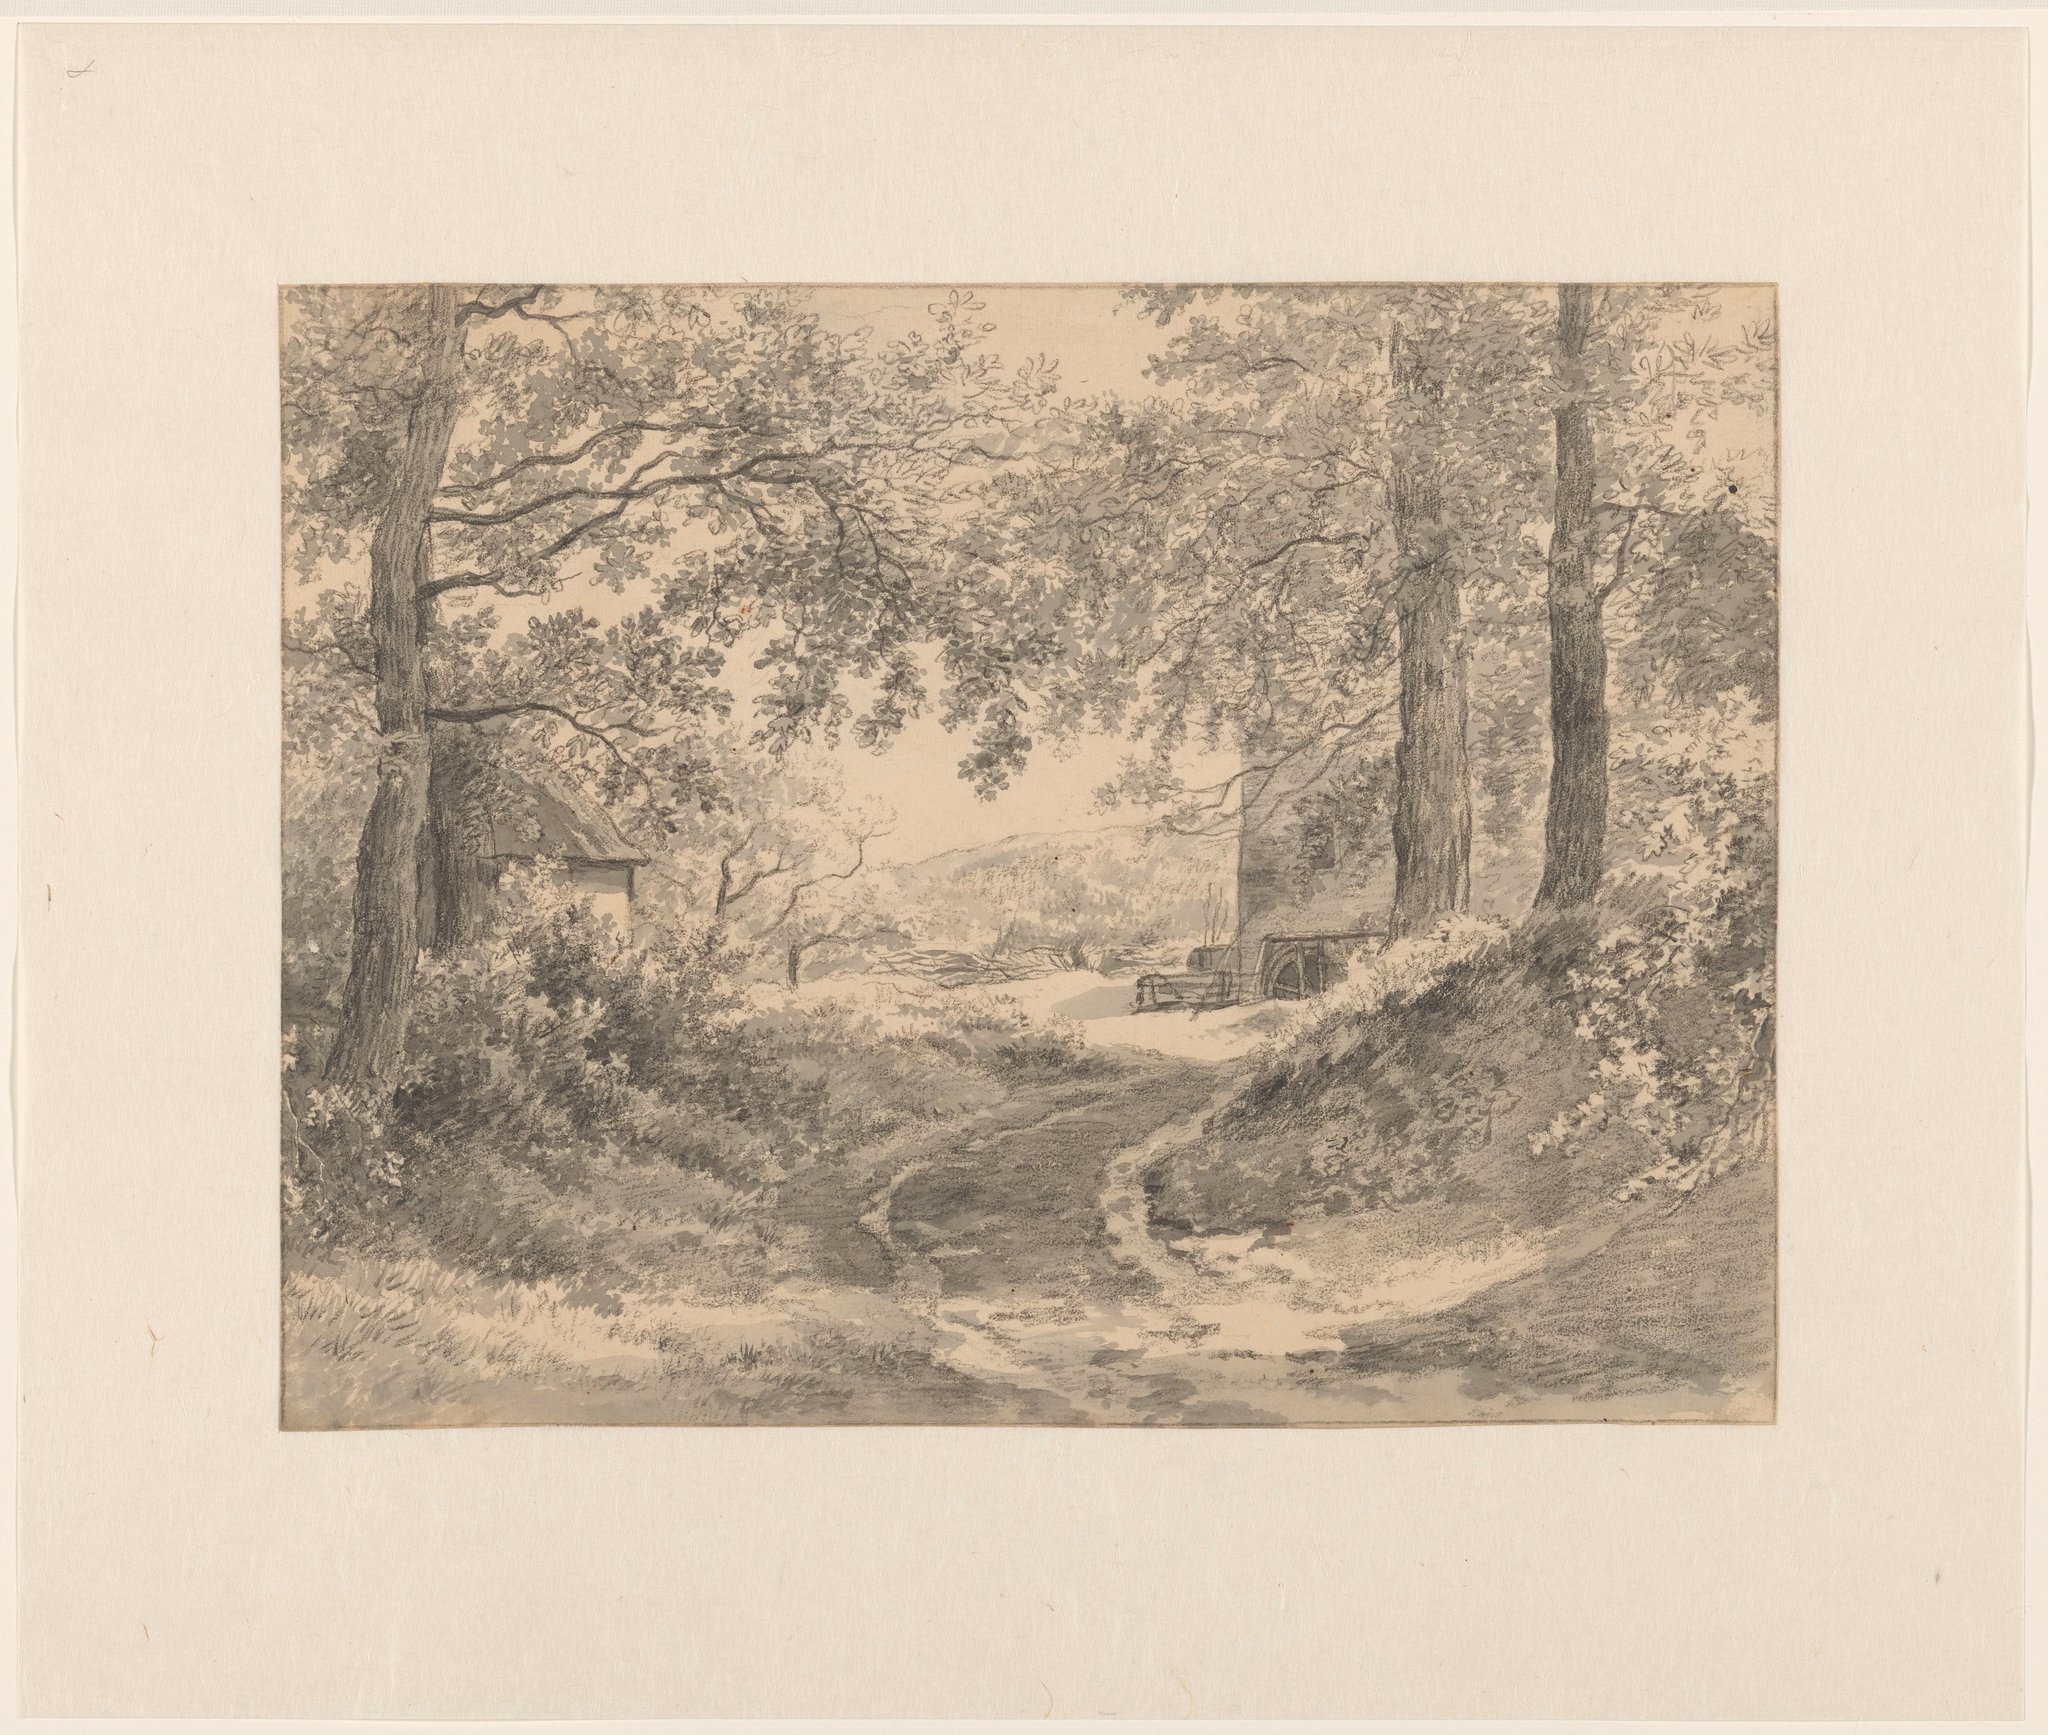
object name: drawing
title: Landschap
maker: gerrit jan michaëlis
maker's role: draughtsman, painter, print maker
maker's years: 1775-1857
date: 1785-1857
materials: chalk, paper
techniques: brush